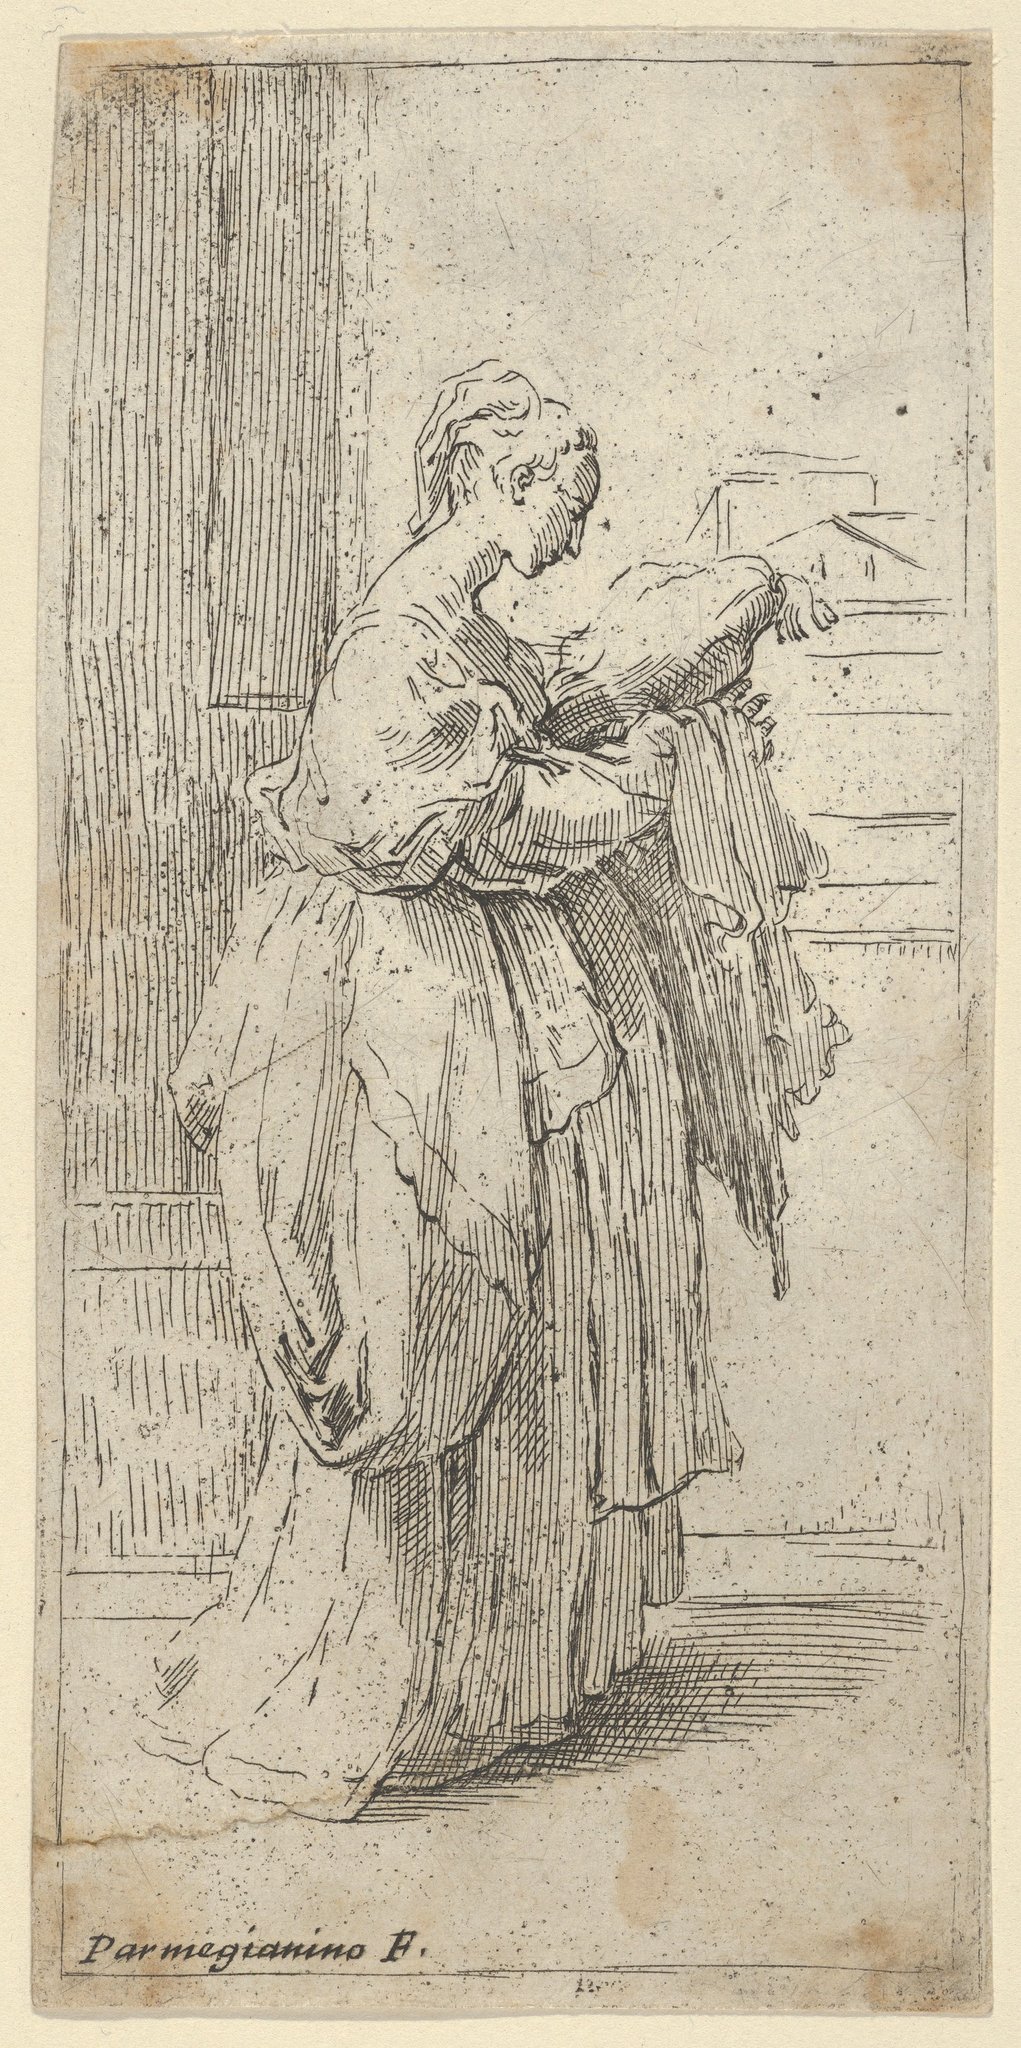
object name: print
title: Girl carrying a cushion, seen in profile facing right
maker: guido reni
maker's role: artist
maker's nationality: italian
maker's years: 1575-1642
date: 1590-1690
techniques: etching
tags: girls,profiles